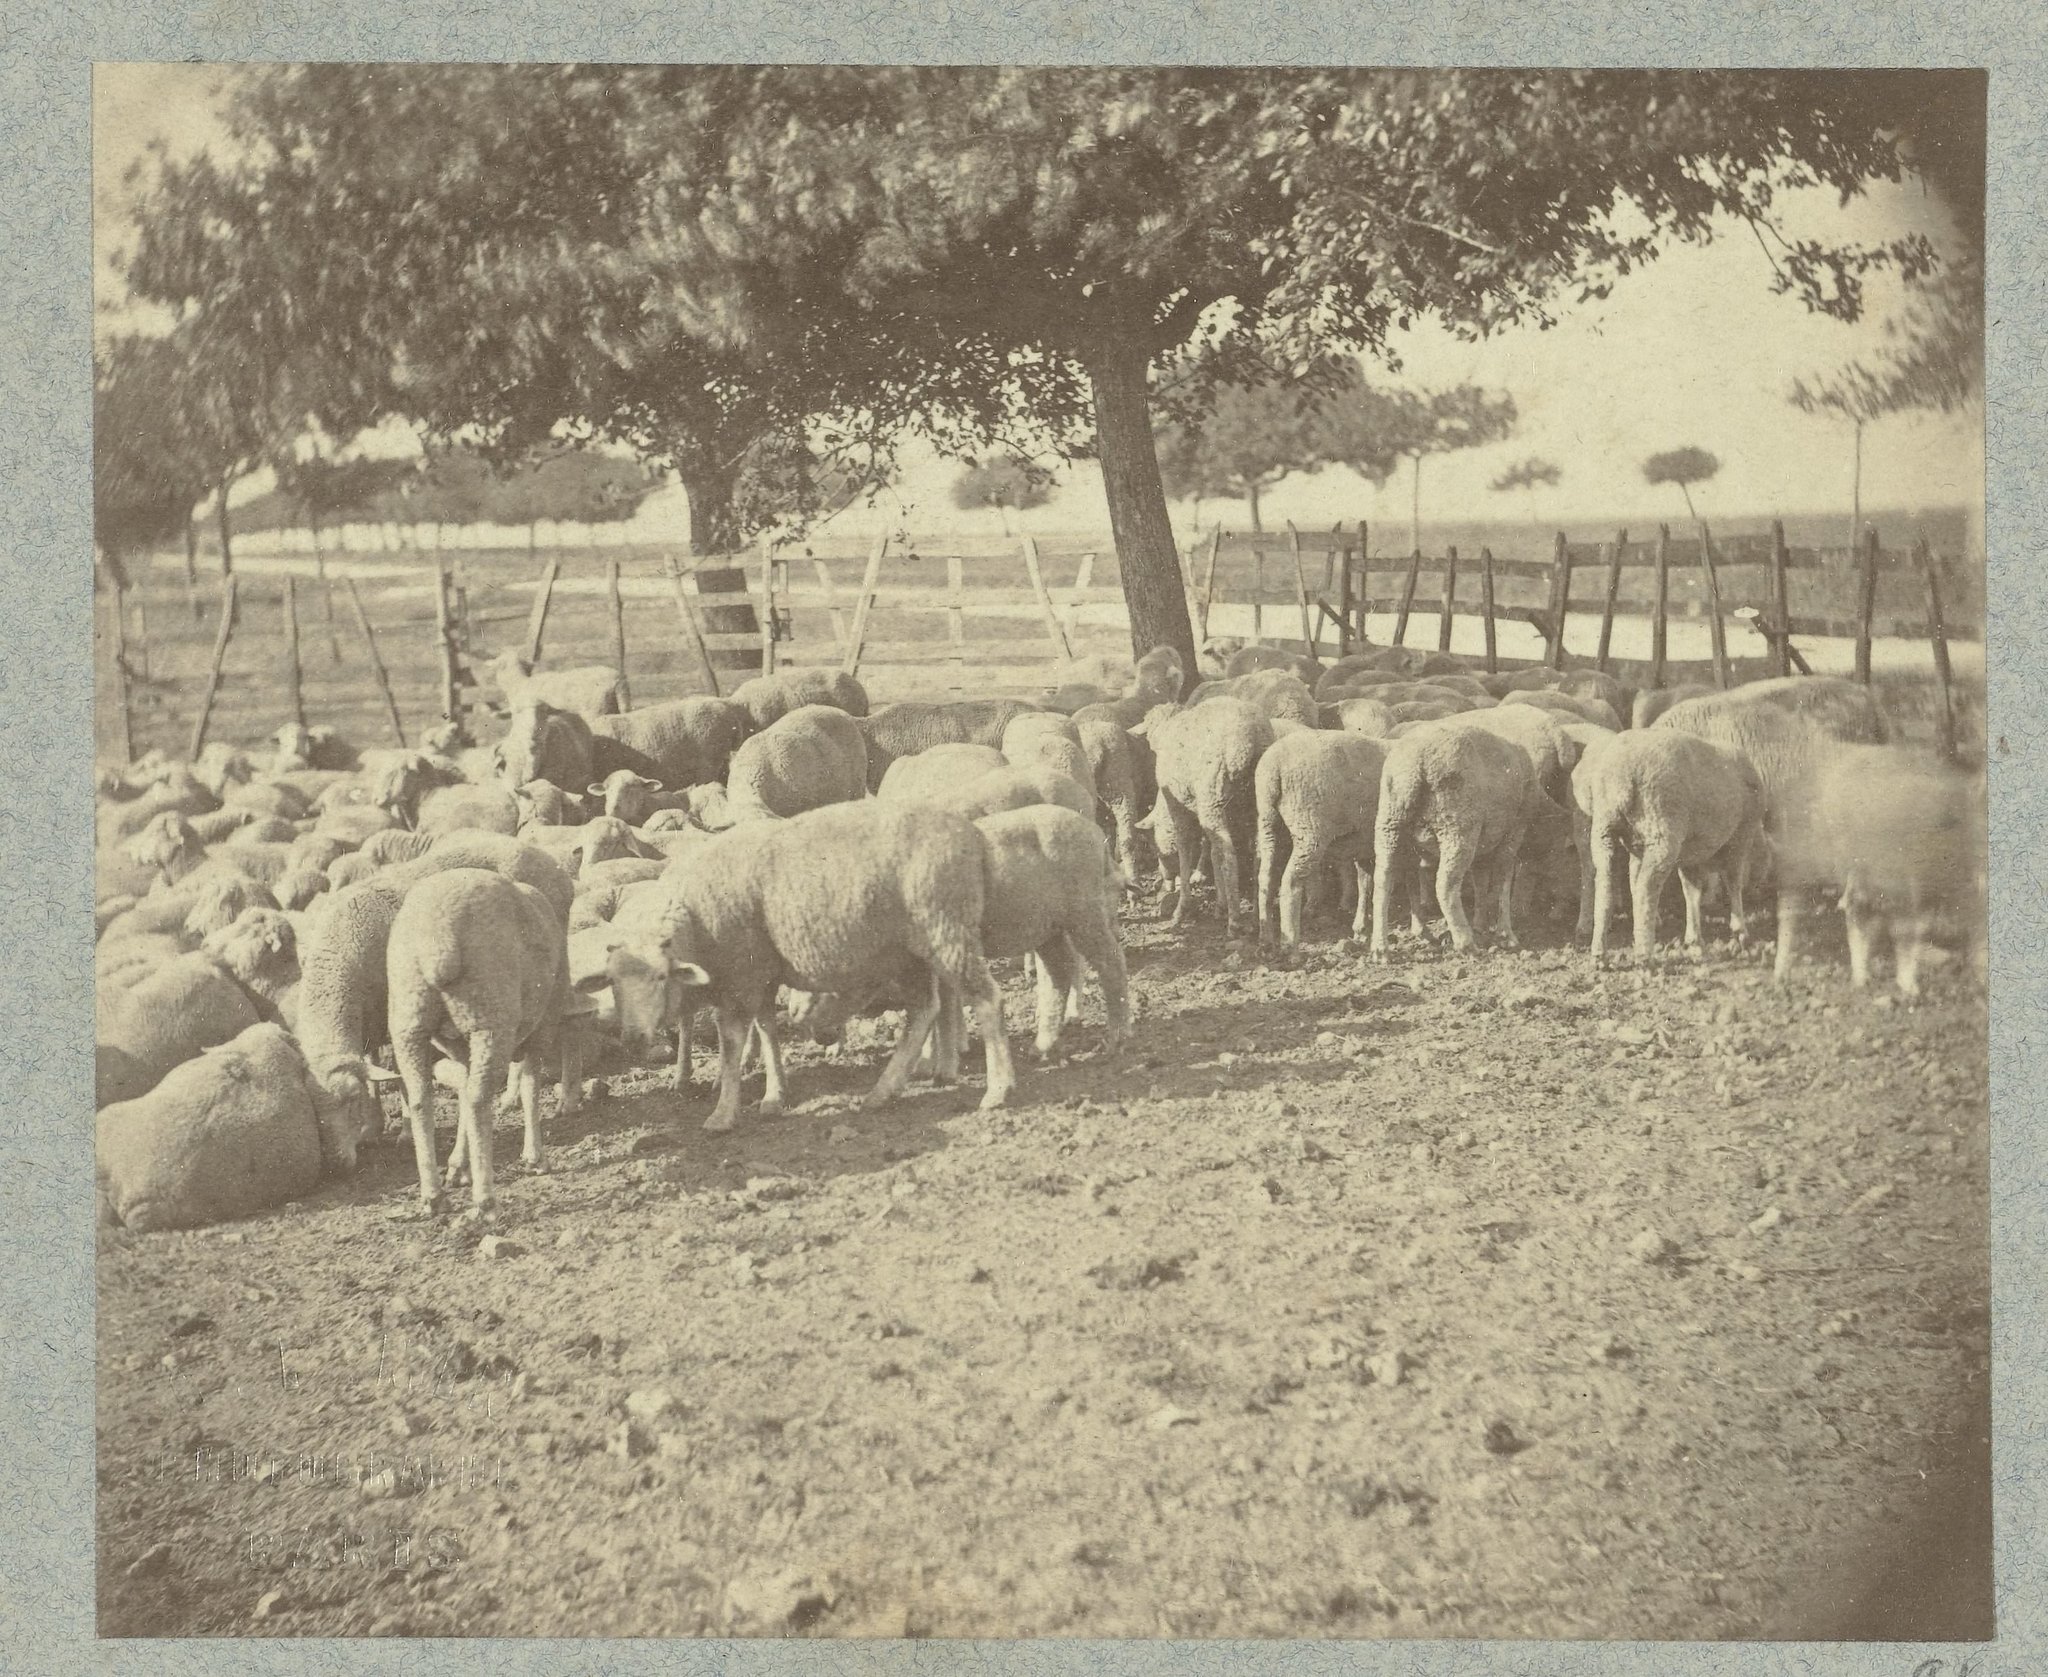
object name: photograph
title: Kudde schapen onder bomen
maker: constant alexandre famin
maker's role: fotograaf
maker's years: 1827-1888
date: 1870-1888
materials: cardboard, paper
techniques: albumen print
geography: france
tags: sheep, france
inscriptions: check stamp: ‘C. FAMIN/ PHOTOGRAPHE/ PARIS’, number: ‘84’